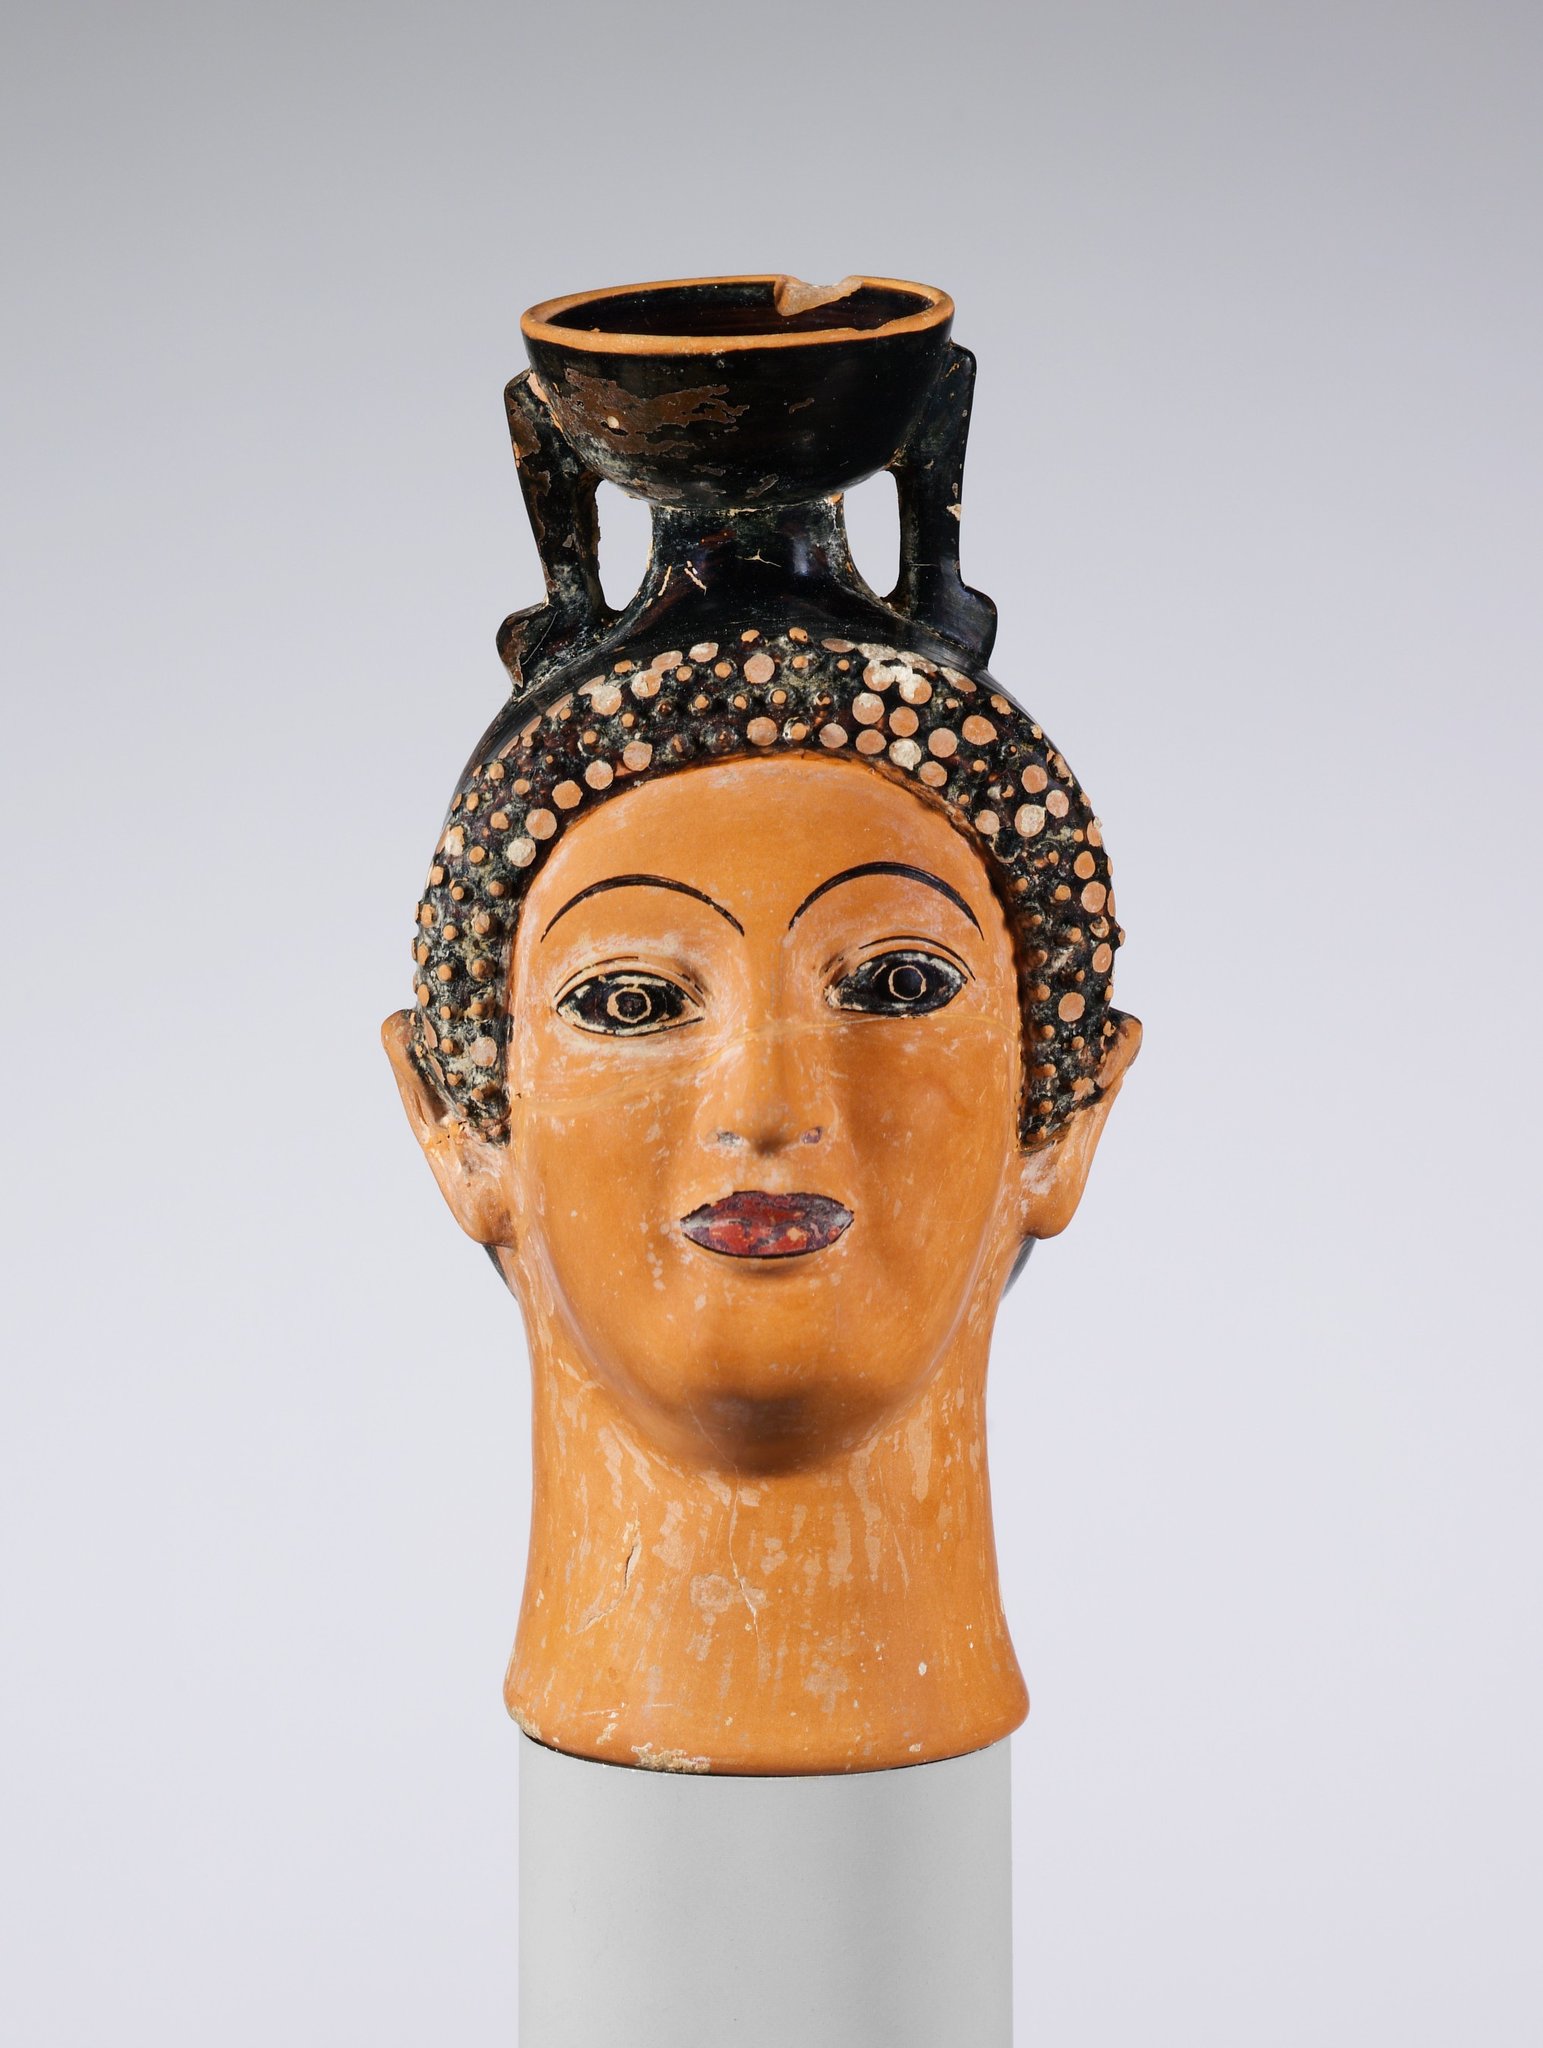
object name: aryballos in the form of a woman's head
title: Terracotta aryballos (perfume bottle) in the shape of a woman's head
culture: greek, attic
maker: oxford class of head vases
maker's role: artist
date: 500 BCE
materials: terracotta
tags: heads,women